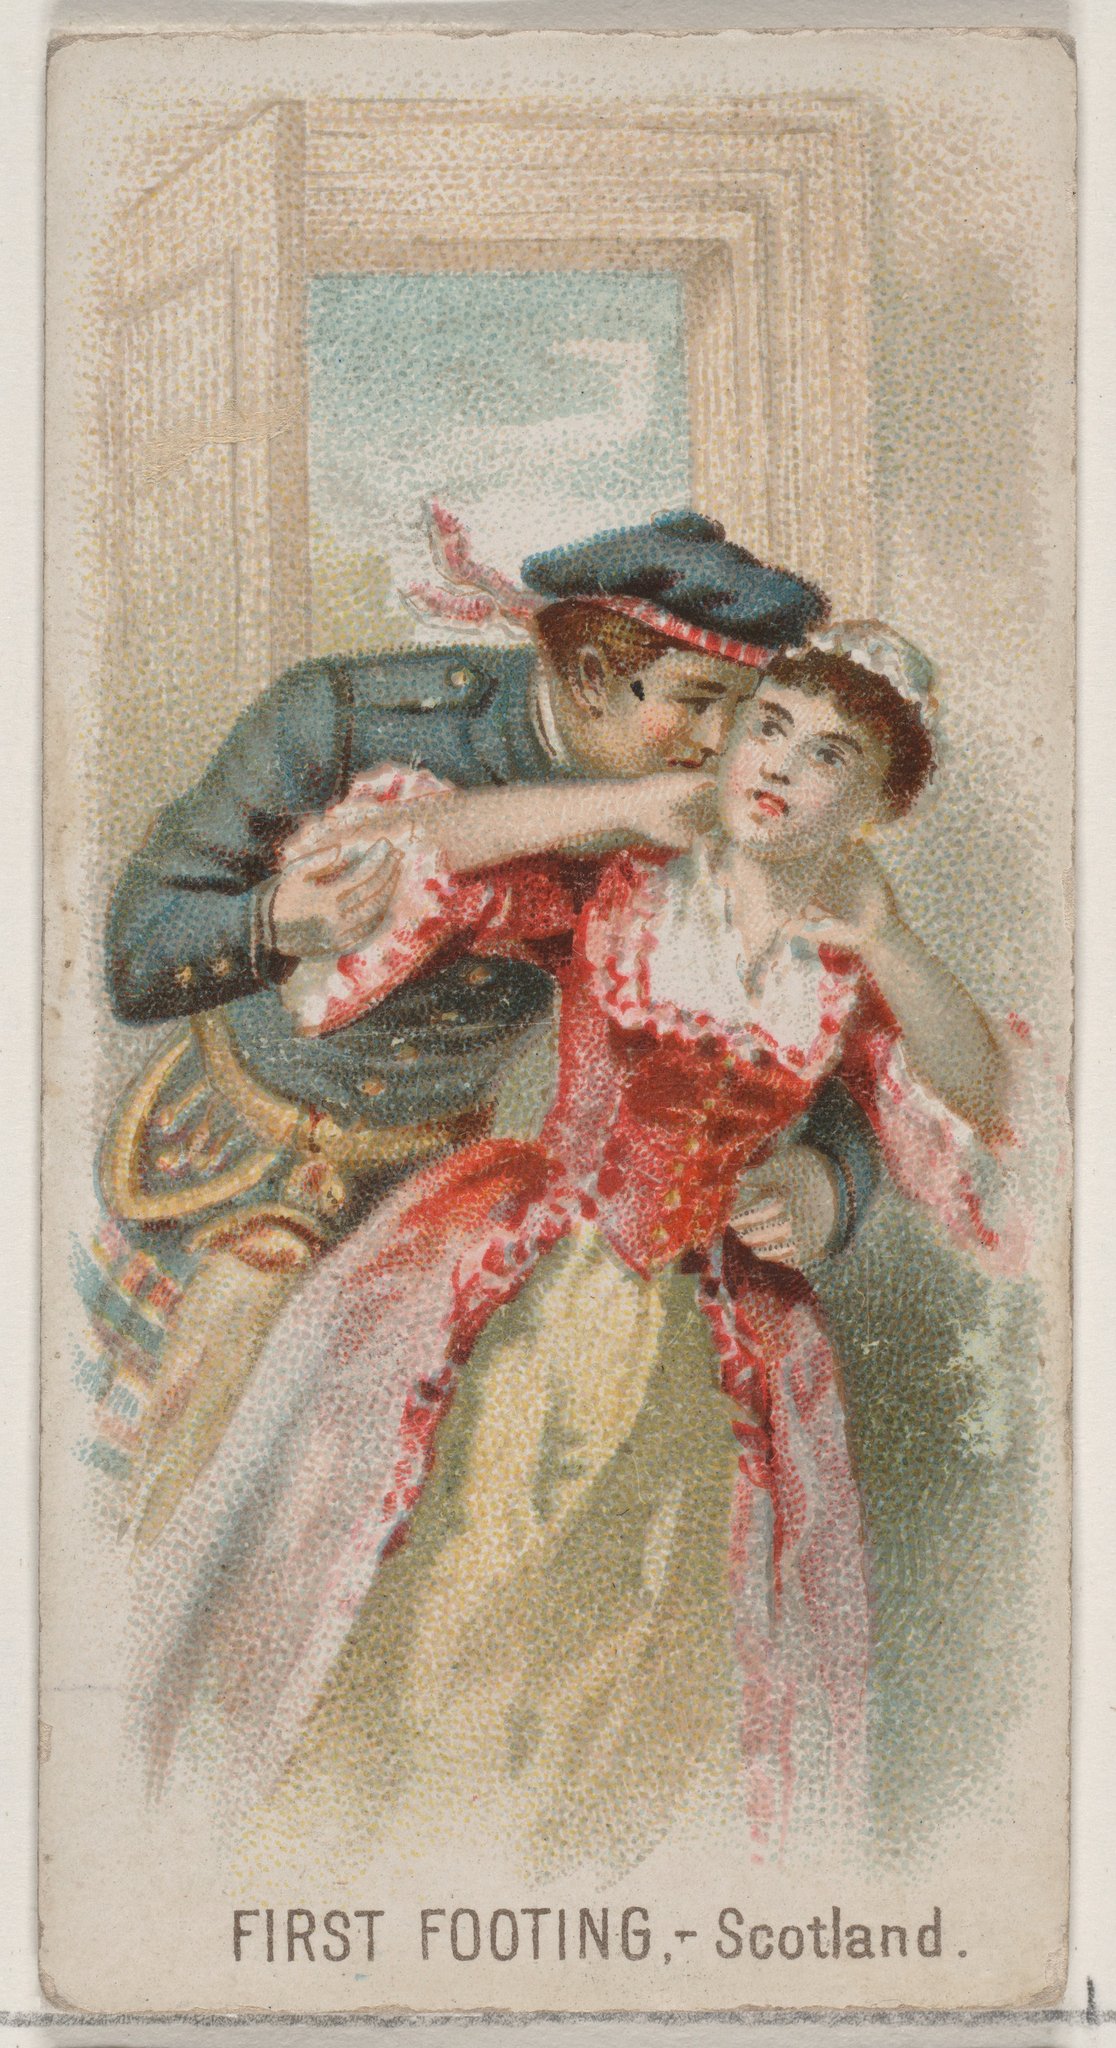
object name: print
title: First Footing, Scotland, from the Holidays series (N80) for Duke brand cigarettes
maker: w. duke, sons & co.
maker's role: publisher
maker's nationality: american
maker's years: 1870-1920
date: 1890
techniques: color lithograph